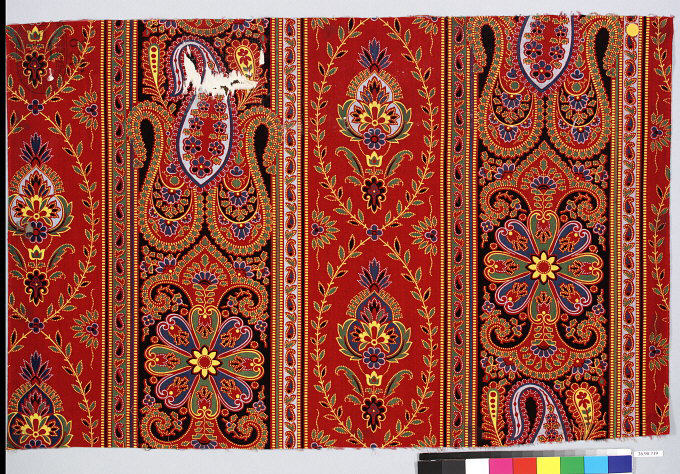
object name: piece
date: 1867-1900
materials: cotton